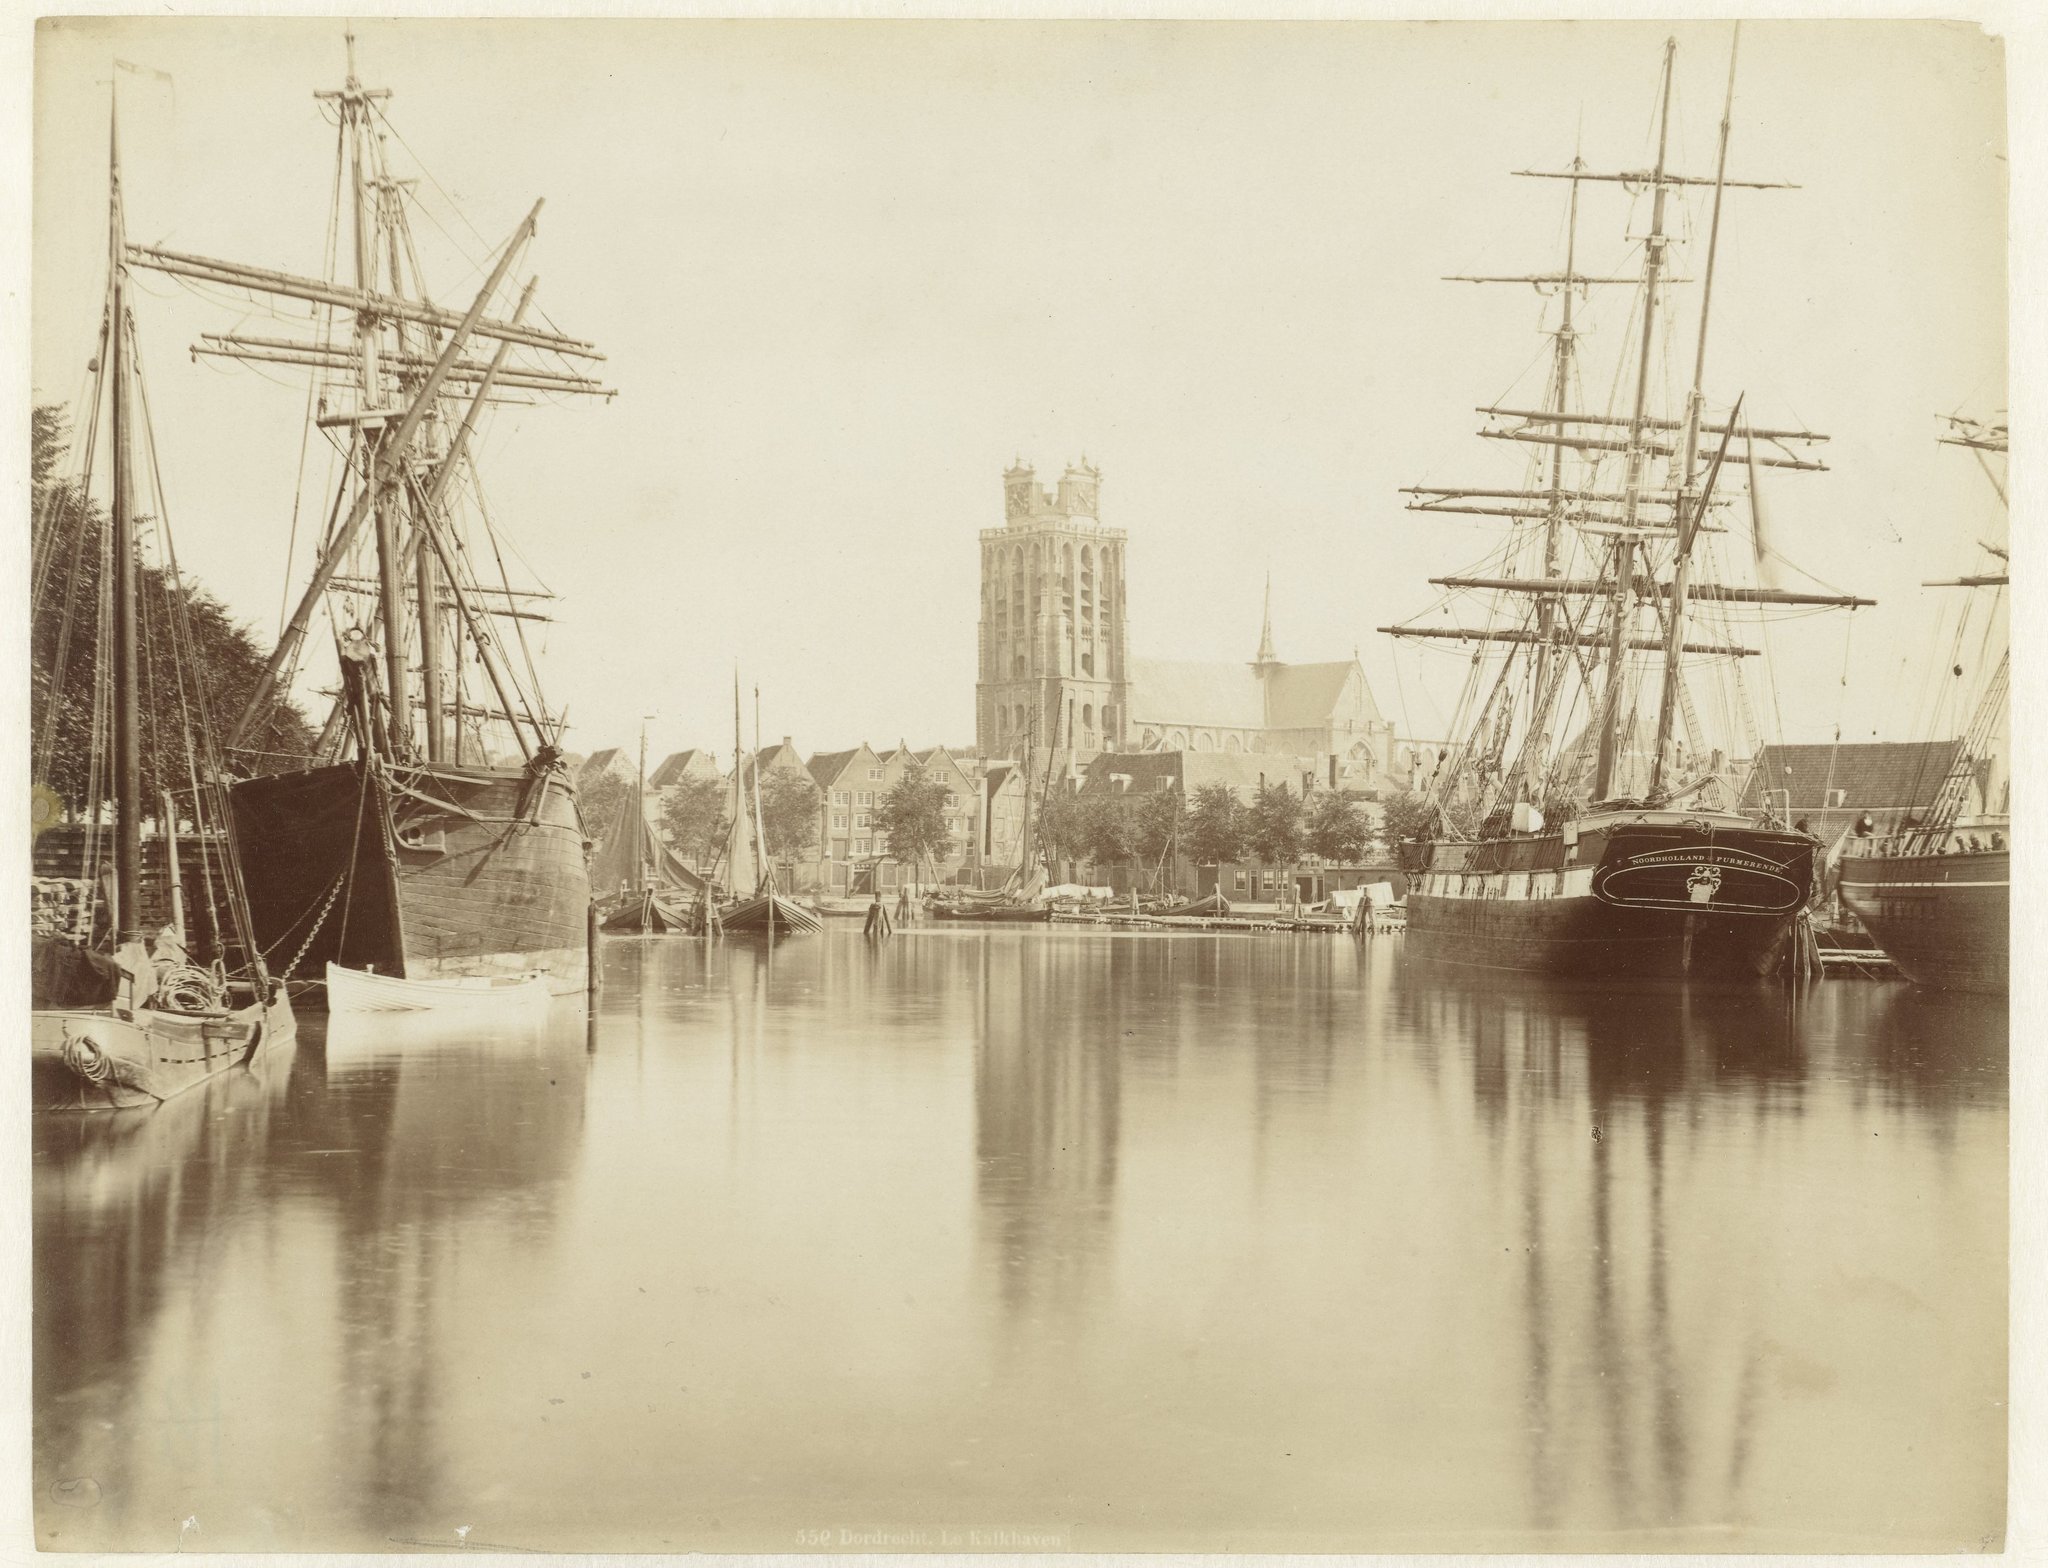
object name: photograph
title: Schepen in de Kalkhaven van Dordrecht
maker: Anonymous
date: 1870-1900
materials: paper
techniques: albumen print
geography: paris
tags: harbour, sailing-ship, sailing-boat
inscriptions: number: ‘180’, inscription: ‘559 Dordrecht Le Kalkhaven’